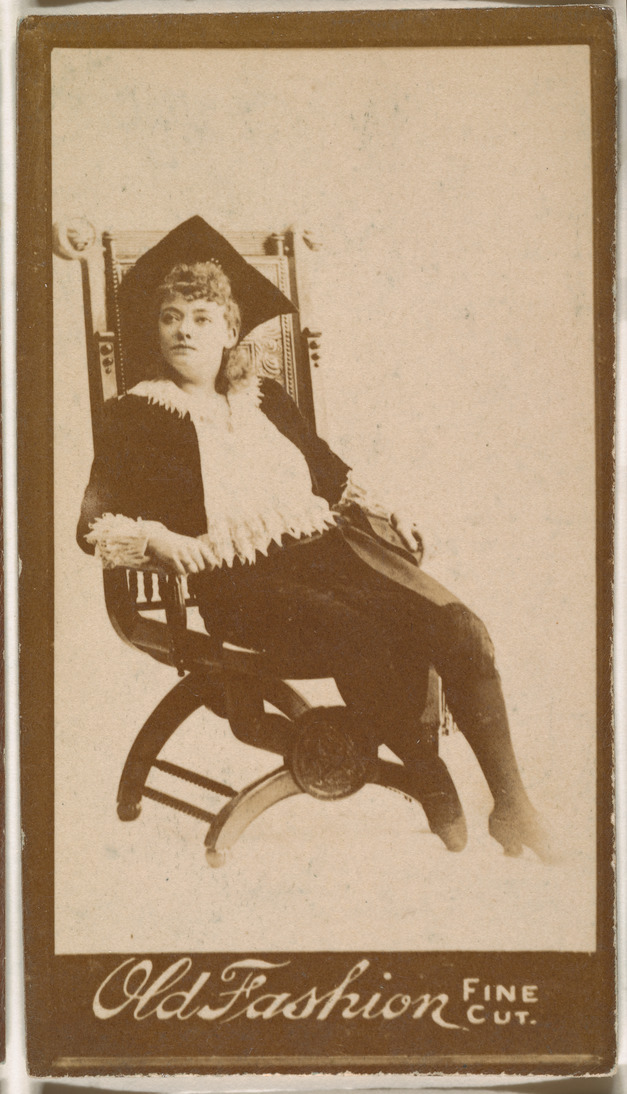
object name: photograph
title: Actress seated in chair, from the Actresses series (N664) promoting Old Fashion Fine Cut Tobacco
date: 1888-1890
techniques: albumen silver print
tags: portraits,women,actresses